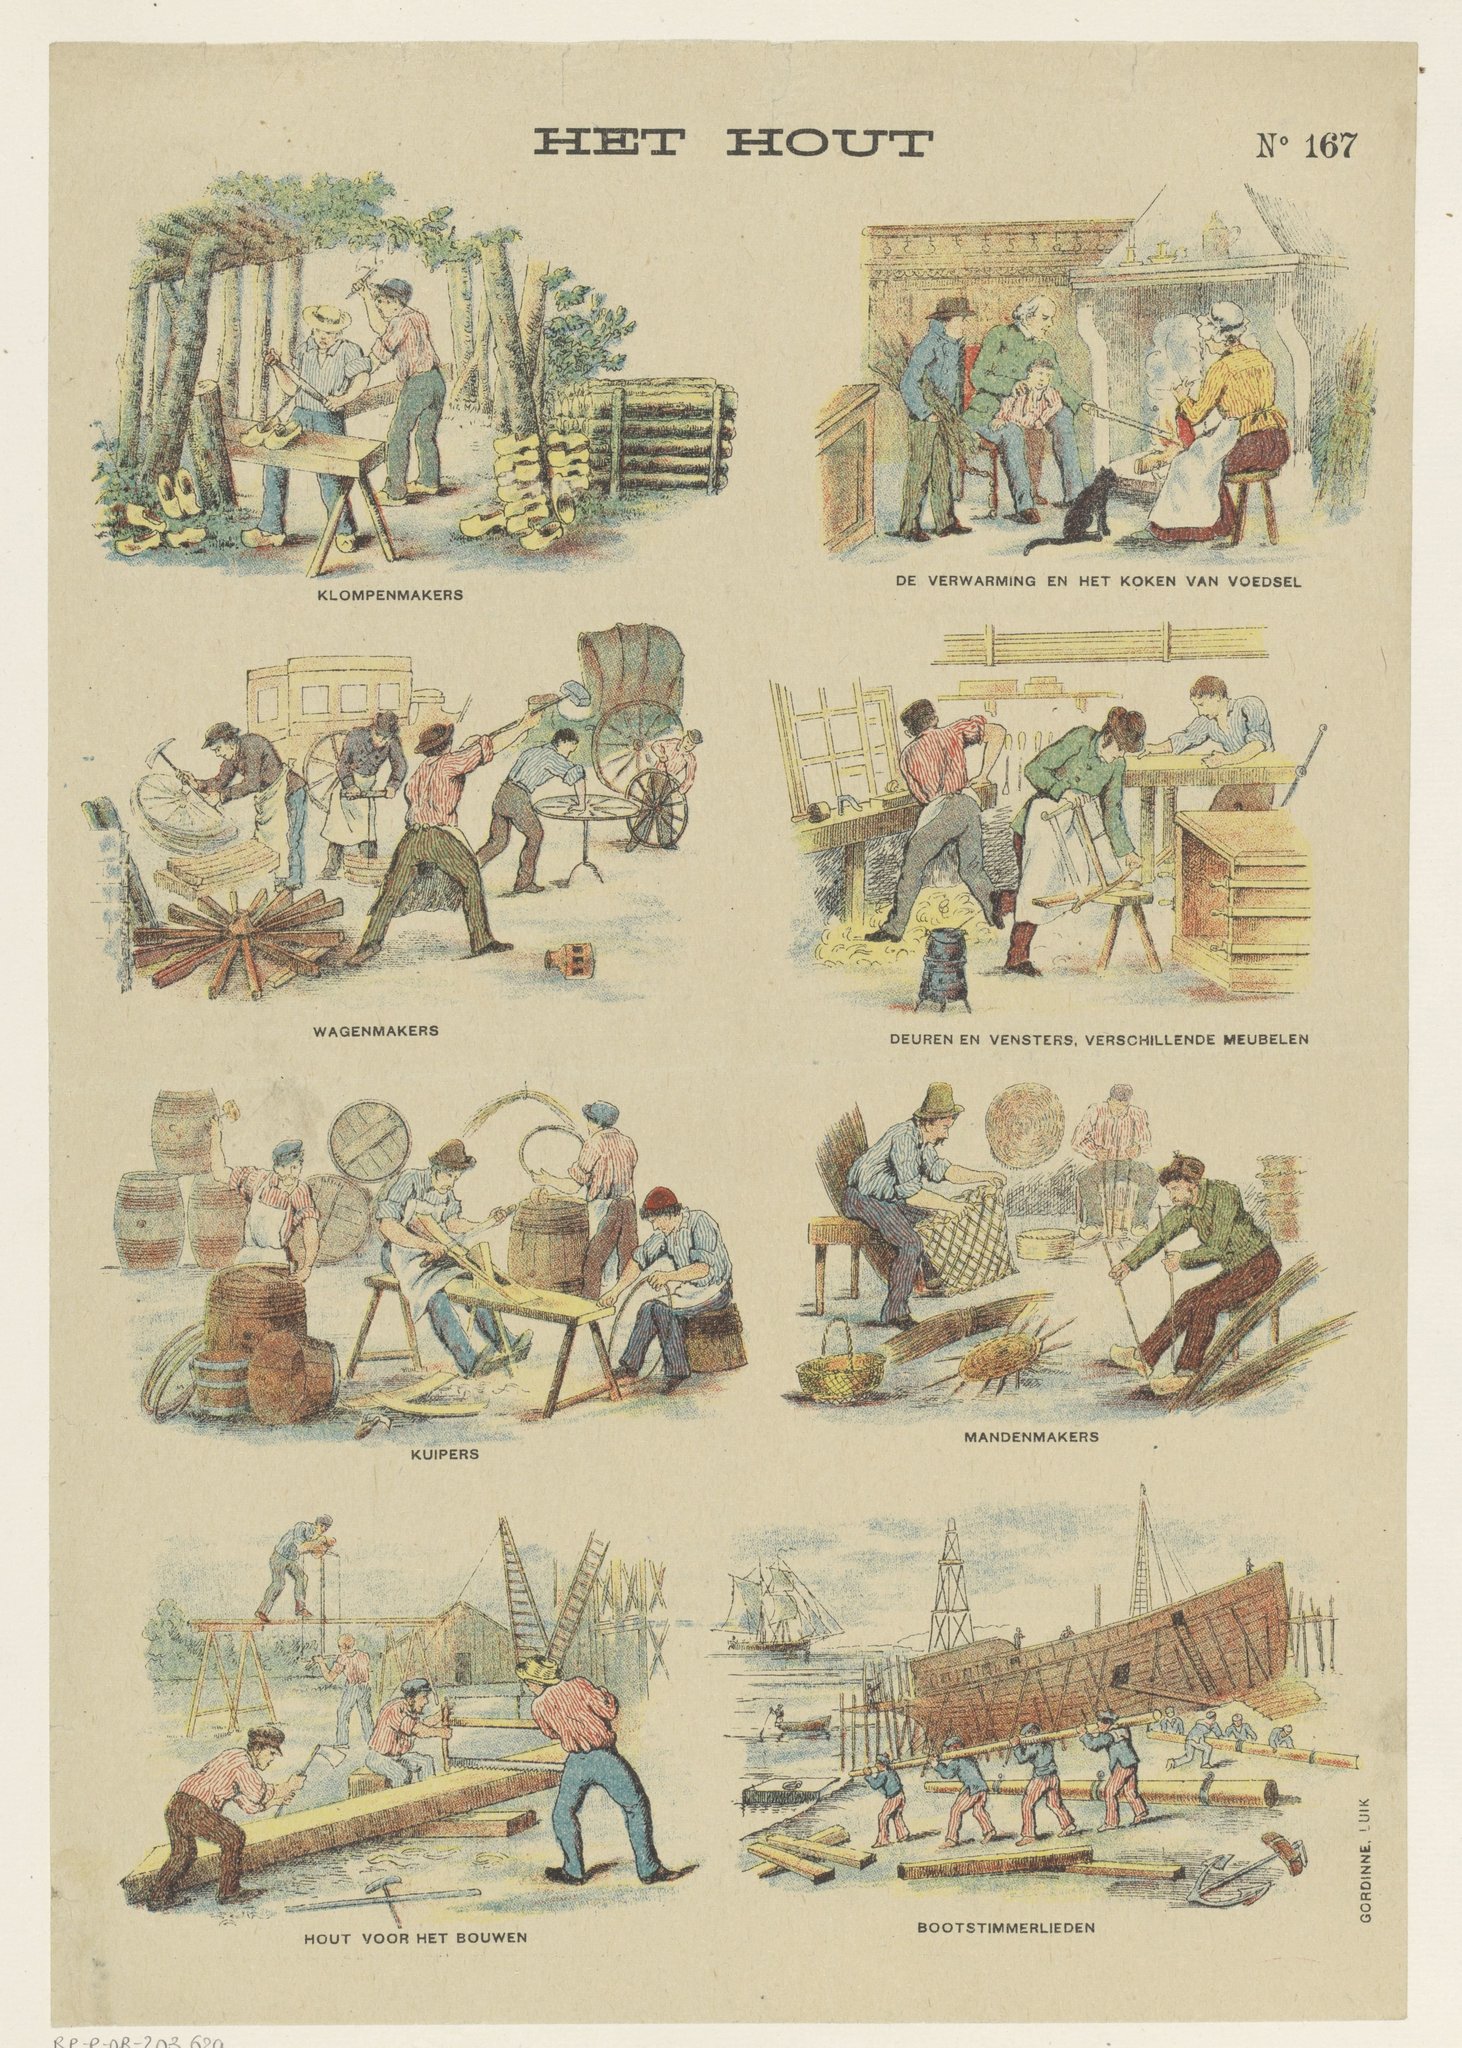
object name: popular print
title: Het hout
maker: Anonymous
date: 1894-1959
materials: paper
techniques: lithograph, letterpress printing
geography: liège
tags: turner in wood, industries ~ wood, handicrafts ~ wood, timber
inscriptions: collector's mark: Lugt 2760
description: Blad met 8 voorstellingen over het gebruik en de bewerking van hout. Onder andere voorstellingen van klompenmakers, wagenmakers en kuipers die gebruik maken van hout. Onder elke afbeelding een onderschrift. Genummerd rechtsboven: No 167.